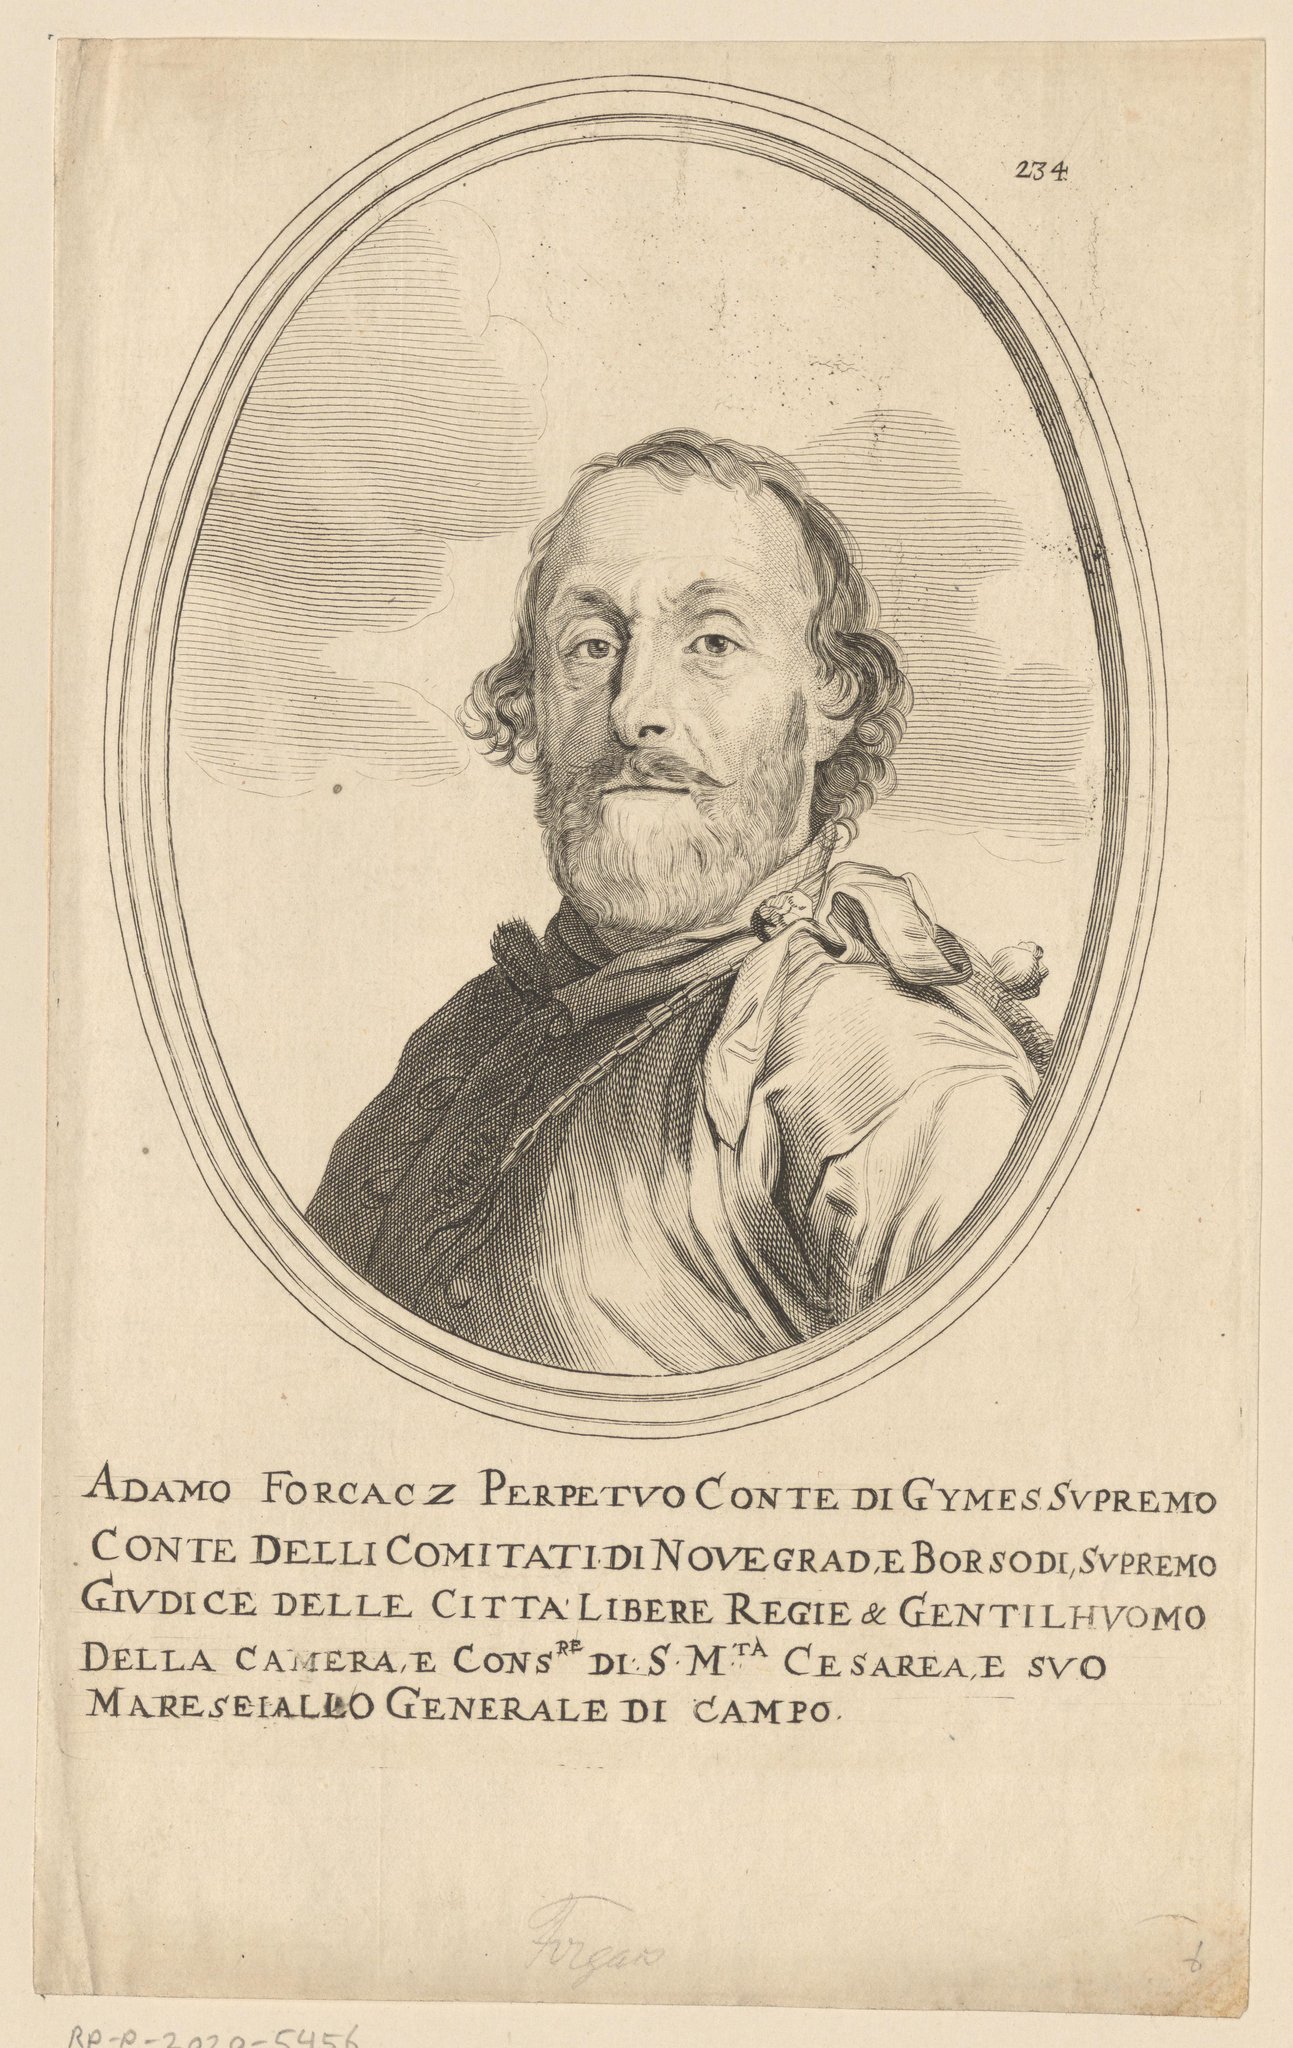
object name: print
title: Portret van Ádám Forgách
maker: cornelis meyssens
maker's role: print maker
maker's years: 1640-1673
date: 1670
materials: paper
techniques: engraving, etching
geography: vienna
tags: historical persons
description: Prent in tweede staat uitgegeven in: Gualdo-Priorato, Galeazzo. Historia di Leopoldo Cesare (...). Wenen: Giovanni Battista Hacque, 1670, dl. 2.